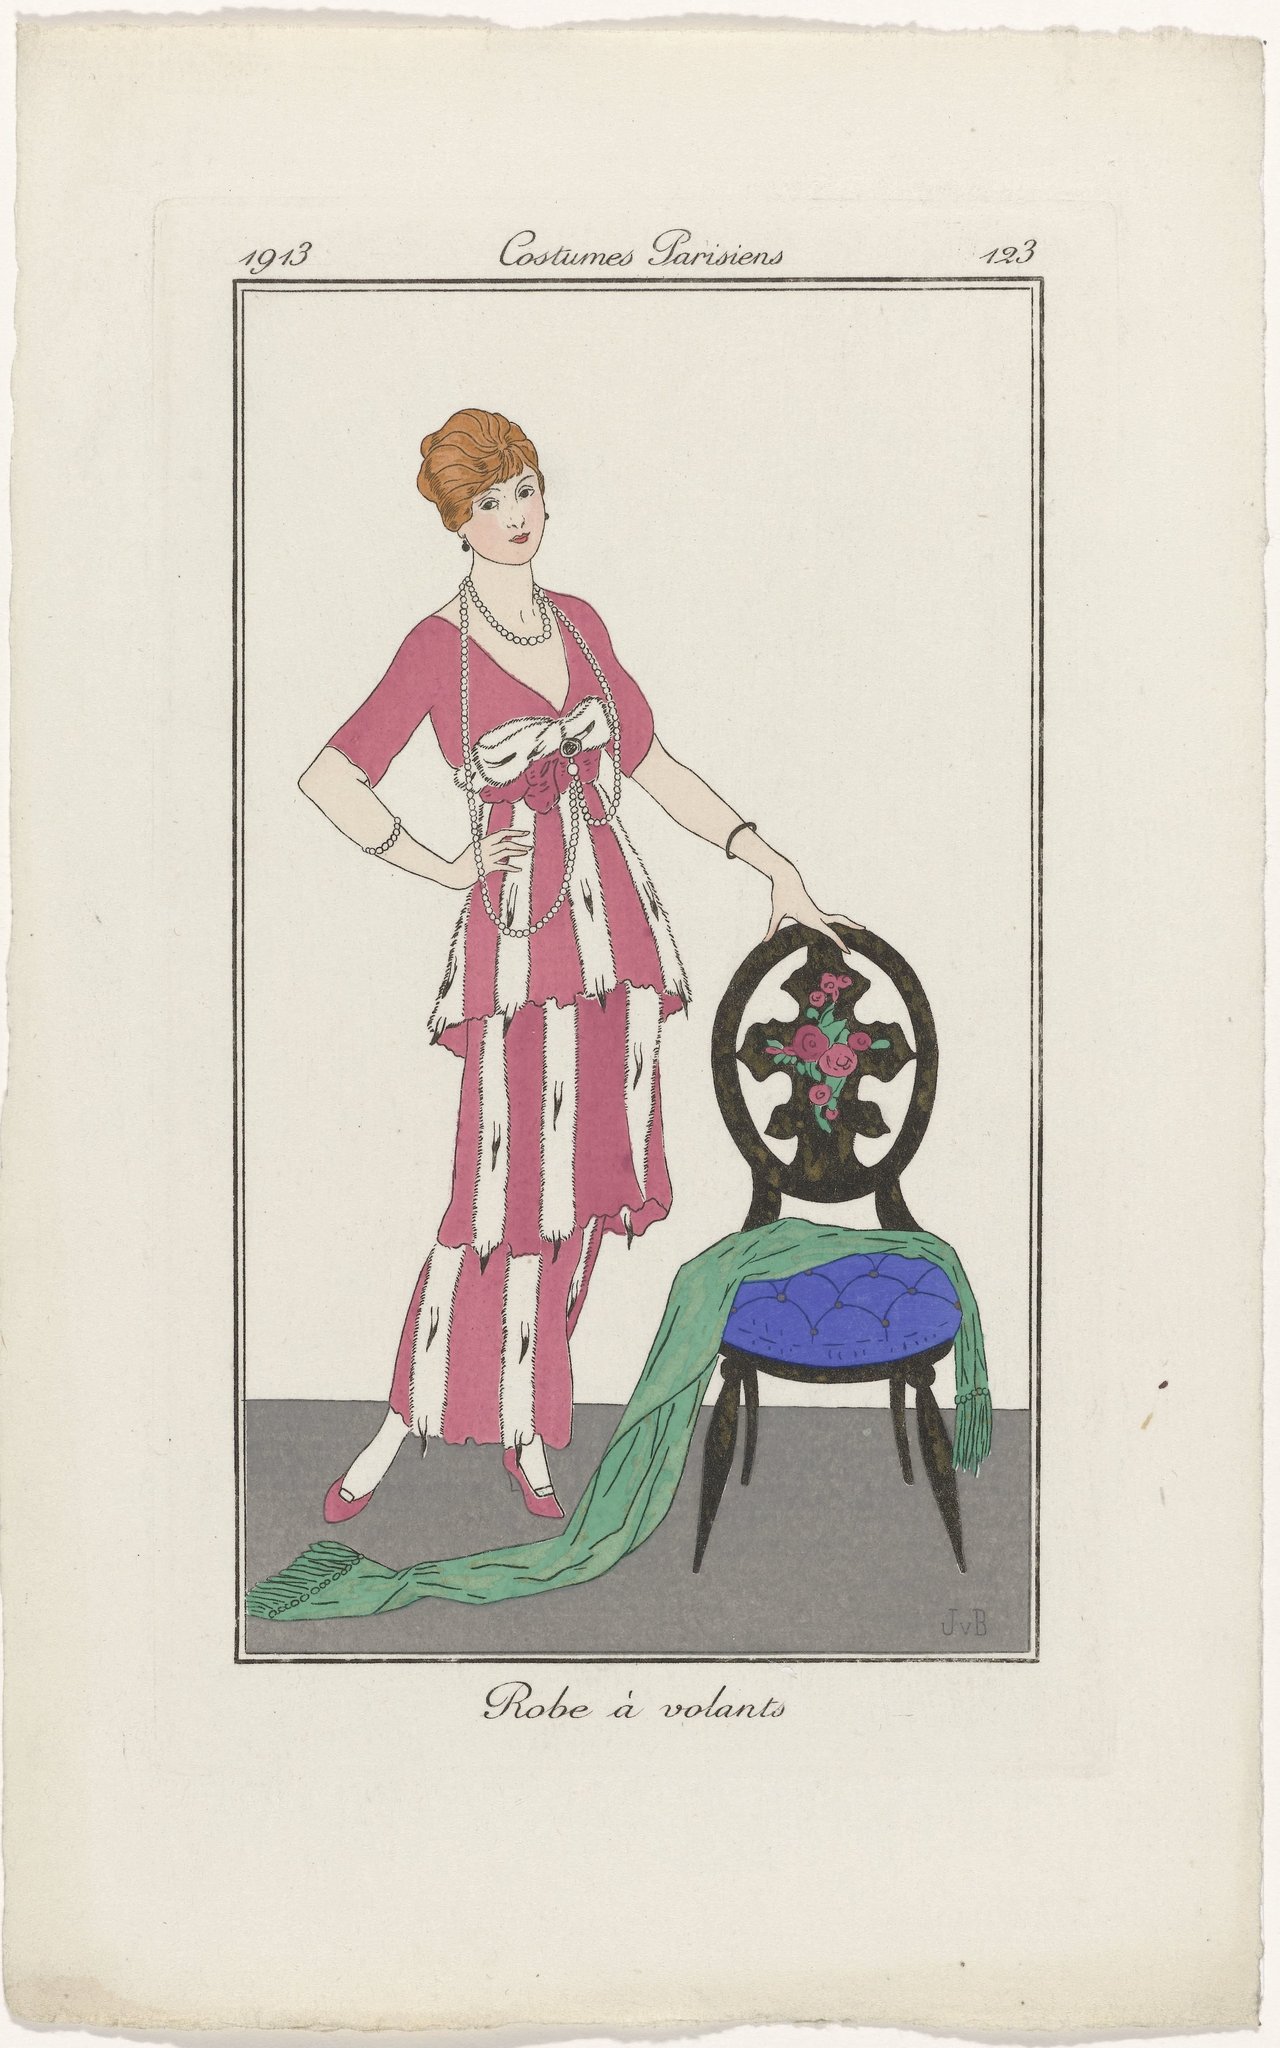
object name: fashion print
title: Journal des Dames et des Modes, Costumes Parisiens, 1913, No. 123 : Robe à volants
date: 1913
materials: paper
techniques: engraving, hand coloring, pochoir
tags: clothing for the upper part of the body (shawl) (+ women's clothes), ornamental parts of clothing (+ fur used for clothes), fashion plates, dress, gown (+ women's clothes), chair, necklace (+ women's clothes)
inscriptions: caption: ‘Robe à volants’, title: ‘Costumes Parisiens’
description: Vrouw in een japon met volants, deels versierd met hermelijnbont(?). Naast haar staat een stoel waarover een sjaal is gedrapeerd. Prent uit het modetijdschrift Journal des Dames et des Modes (1912-1914).